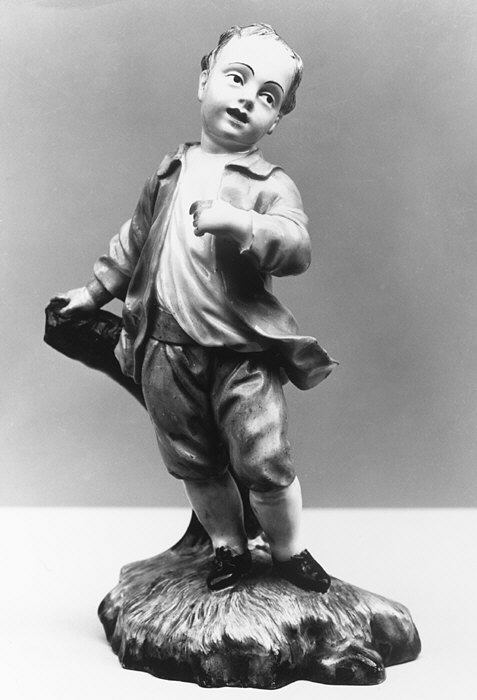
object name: figure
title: Boy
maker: höchst manufactory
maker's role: manufactory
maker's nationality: german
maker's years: 1746-1796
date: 1765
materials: hard paste porcelain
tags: boys